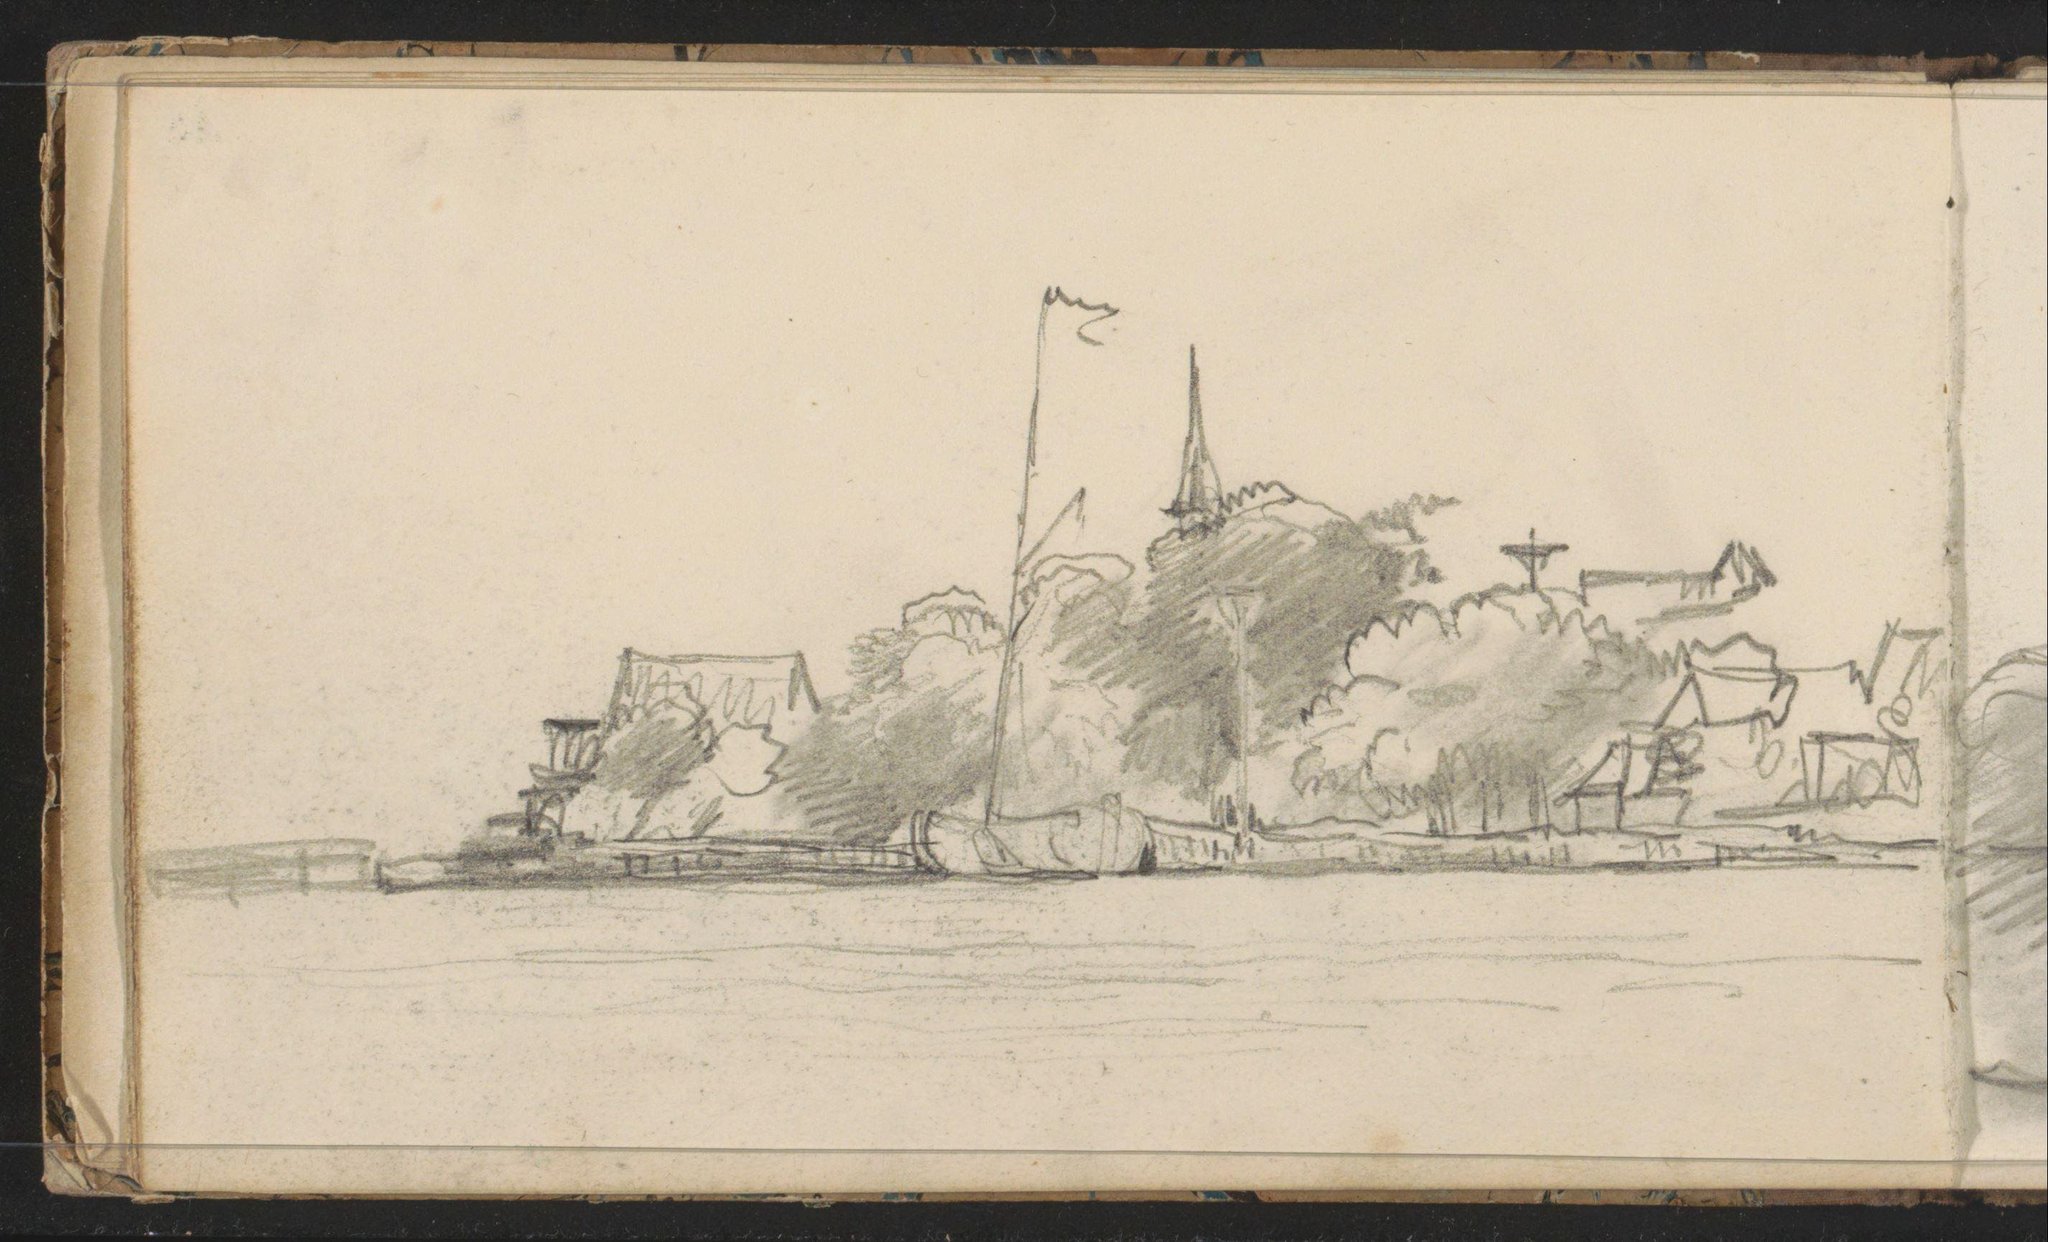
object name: sketchbook leaf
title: Gezicht op een dorp aan het water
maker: arnoldus johannes eymer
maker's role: draughtsman, print maker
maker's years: 1803-1863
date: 1803-1818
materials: paper, pencil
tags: prospect of village, silhouette of village, landscapes with waters, waterscapes, seascapes (in the temperate zone)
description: Bladzijde 22 uit een schetsboek met 74 bladzijden.